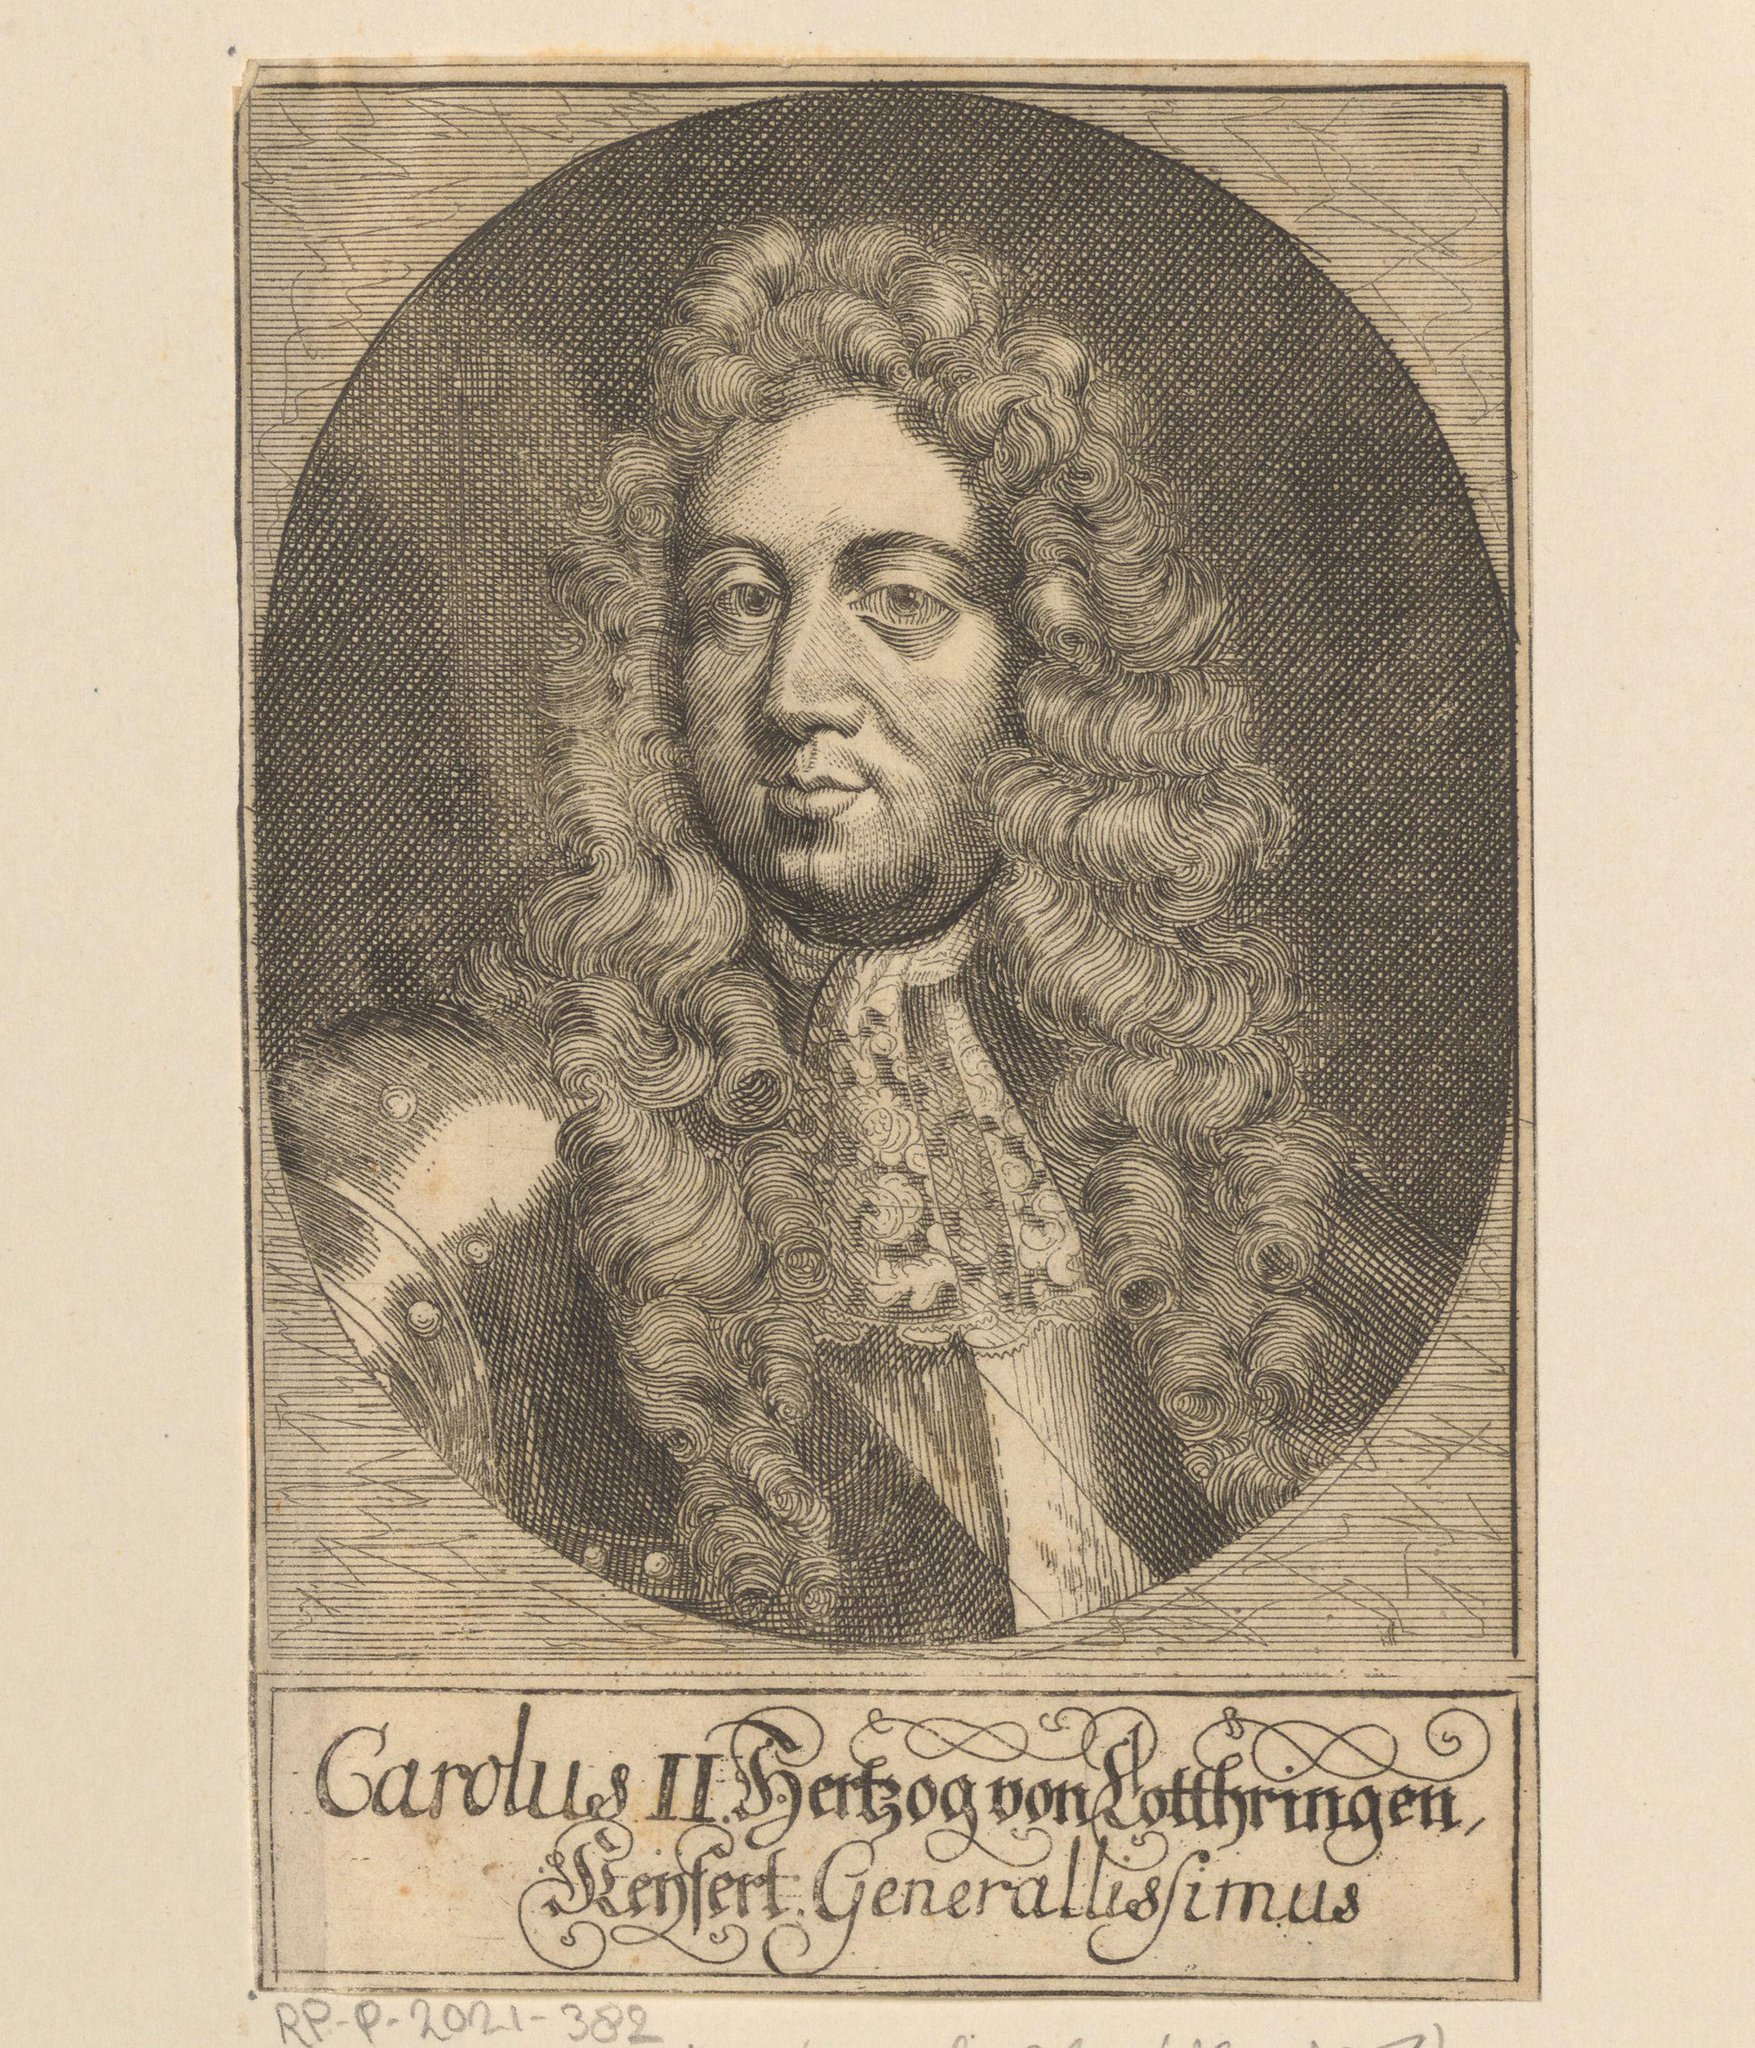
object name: print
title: Portret van Karel V Leopold, hertog van Lotharingen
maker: Anonymous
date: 1689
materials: paper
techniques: etching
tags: vienna, other sovereign, historical persons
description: Prent mogelijk uit: Historischer Kern, oder kurtze Chronica. S.l.s.n., 1689.